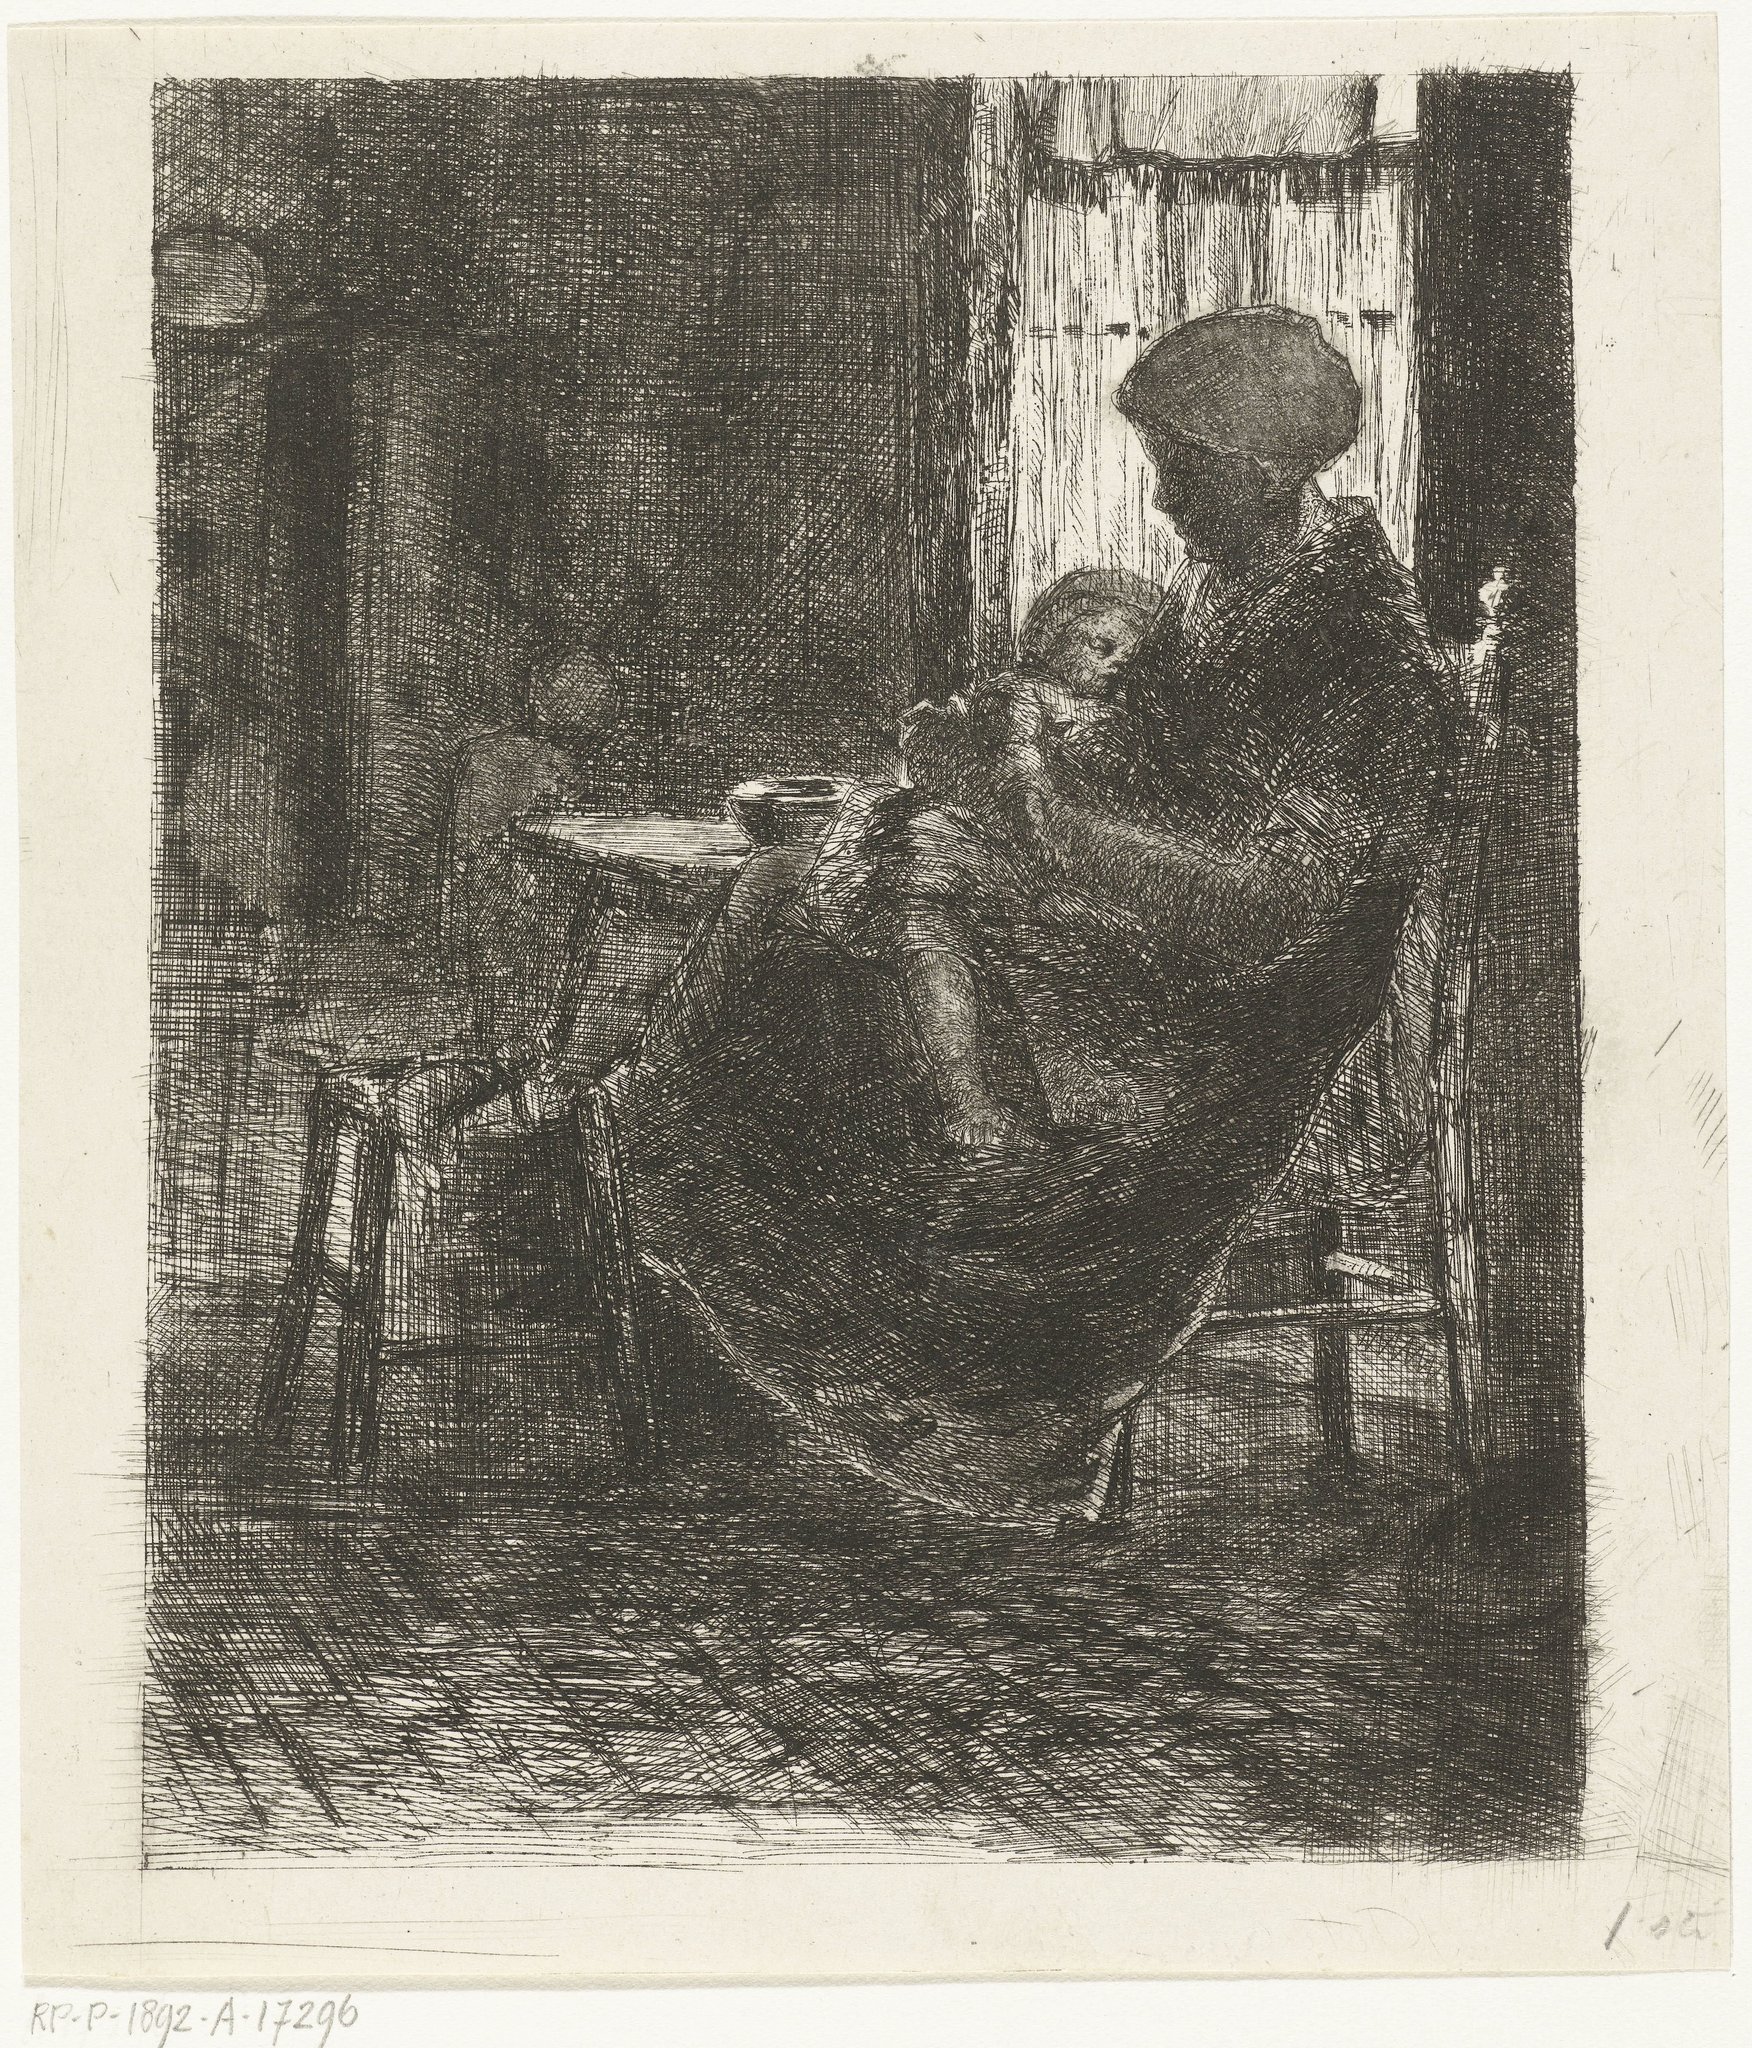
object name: print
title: Vrouw met slapend kind op schoot zit bij raam in een interieur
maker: bernardus johannes blommers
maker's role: draughtsman, print maker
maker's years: 1845-1914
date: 1855-1892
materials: paper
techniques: drypoint, etching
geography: netherlands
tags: mother and baby or young child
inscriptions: collector's mark: Lugt 2228